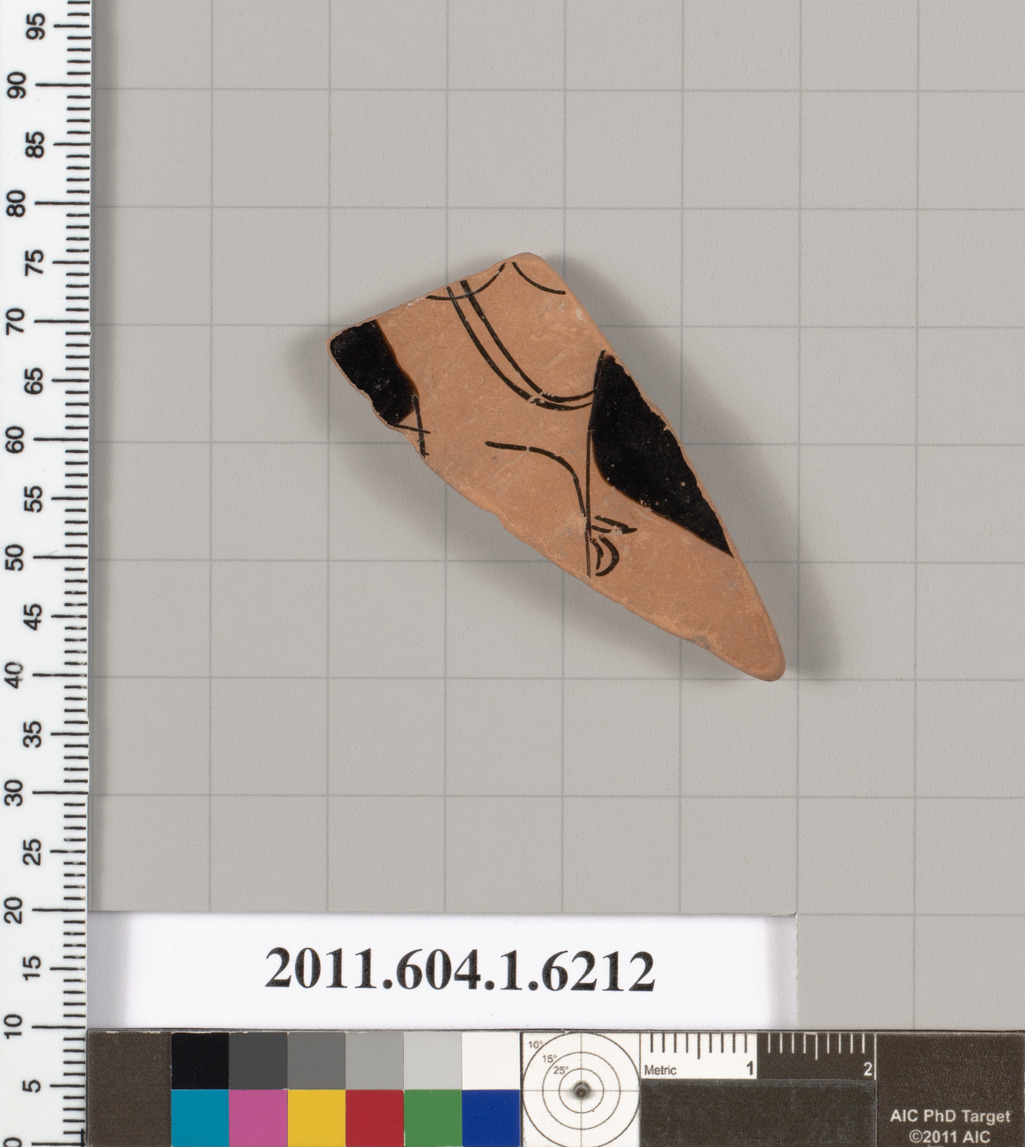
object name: kylix fragment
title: Terracotta fragment of a kylix (drinking cup)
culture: greek, attic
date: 510-500 BCE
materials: terracotta